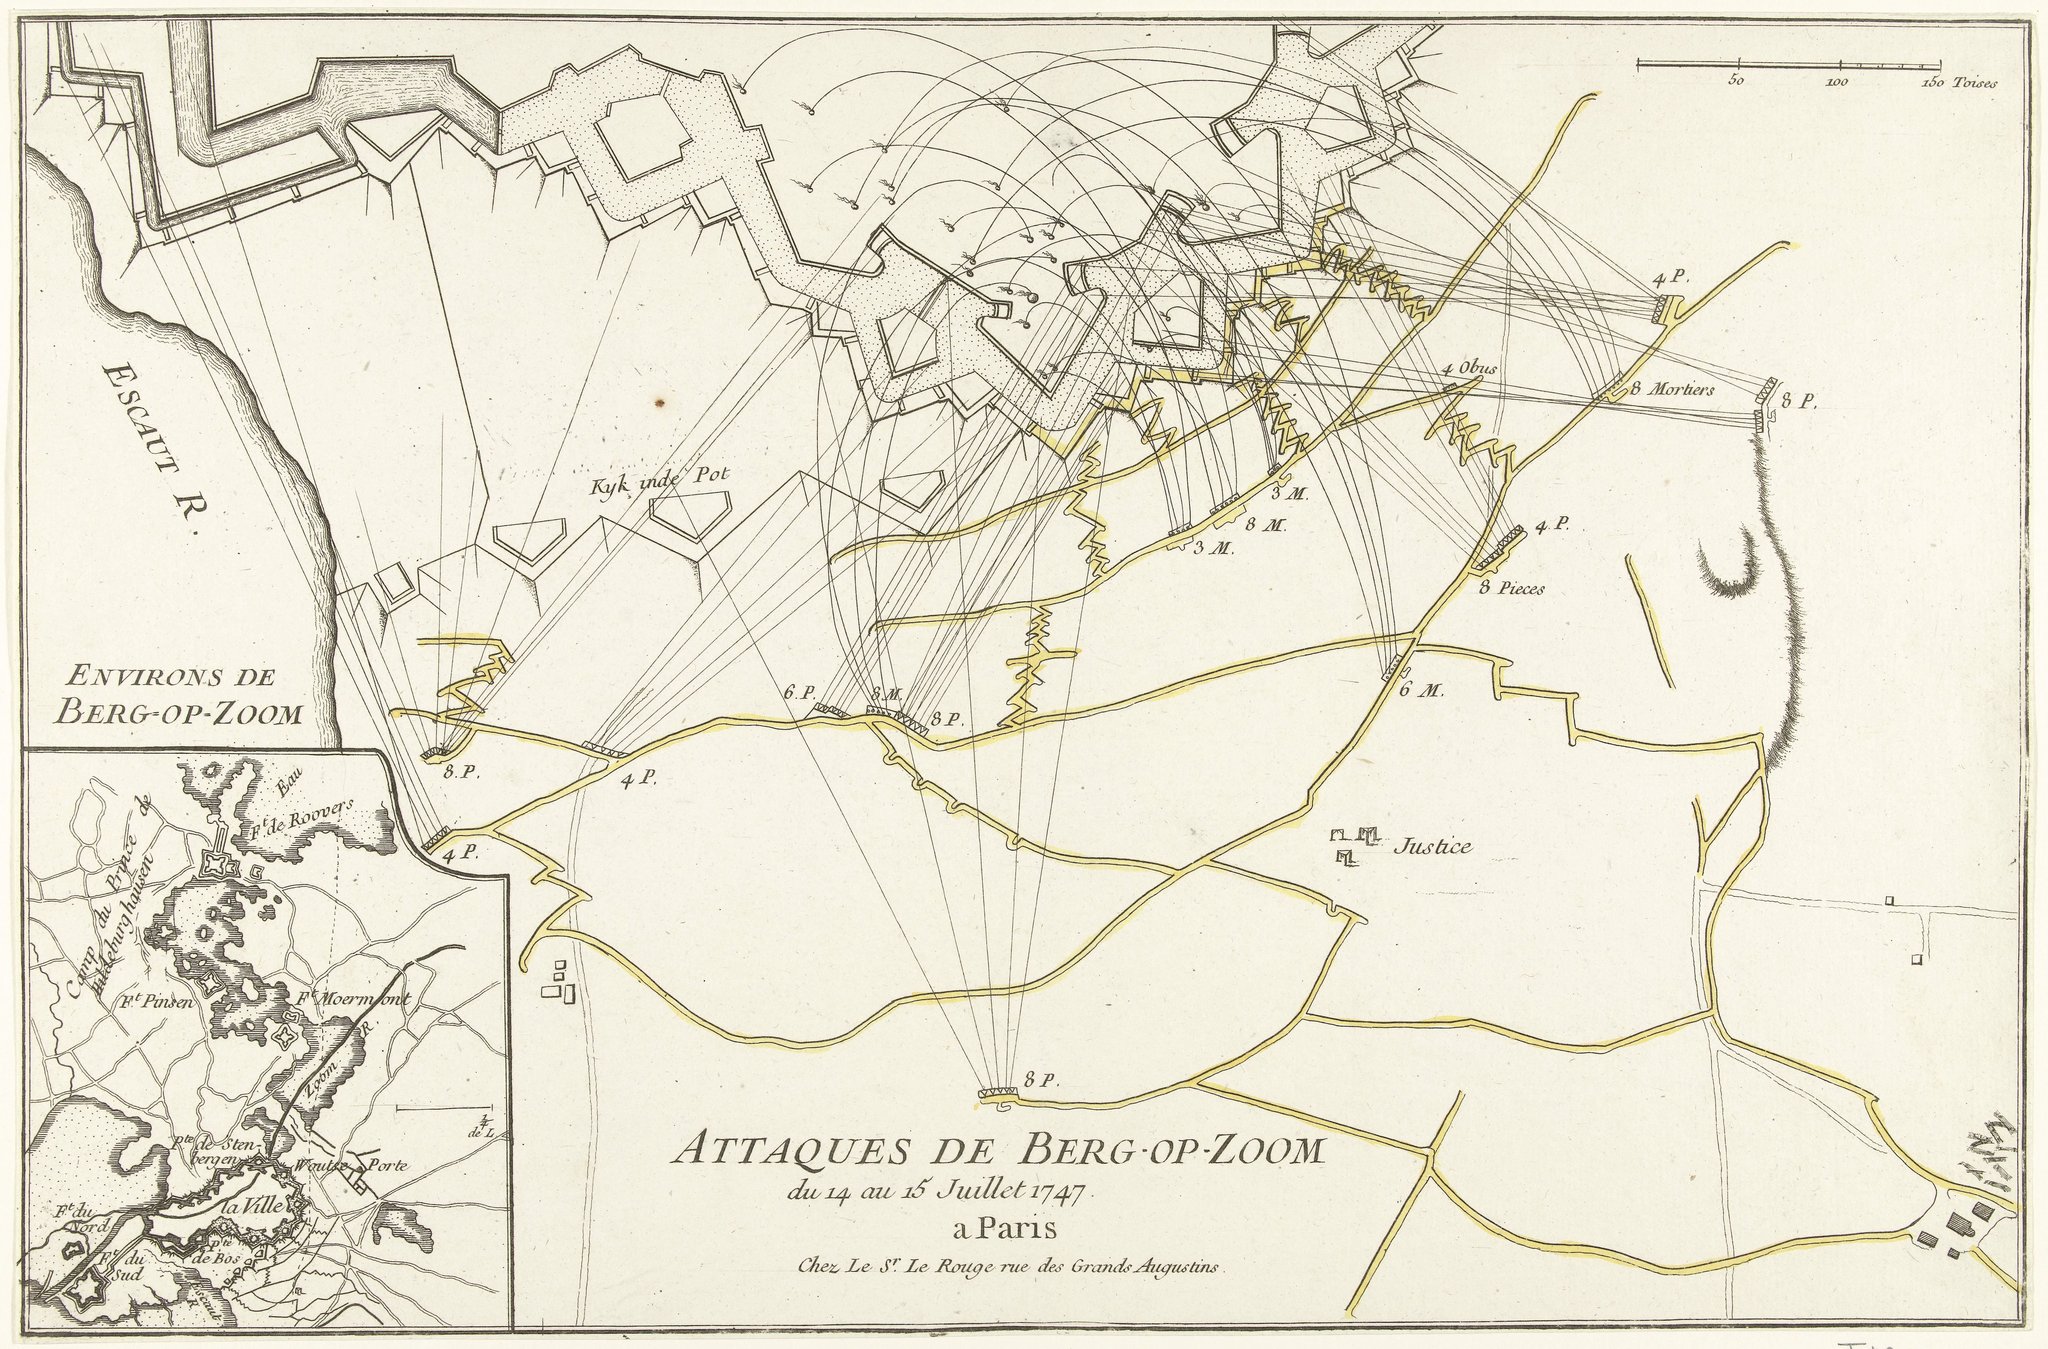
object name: print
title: Attaques de Berg-op-Zoom du 14 au 15 Juillet 1747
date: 1747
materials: paper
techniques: etching, hand coloring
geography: paris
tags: siege, position war, bergen op zoom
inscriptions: collector's mark: Lugt 2228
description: De beschieting van Bergen op Zoom door de Fransen op 14 en 15 juli 1747, de loopgraven ingekleurd. Linksonder een inzet met een kaartje van het groter gebied.